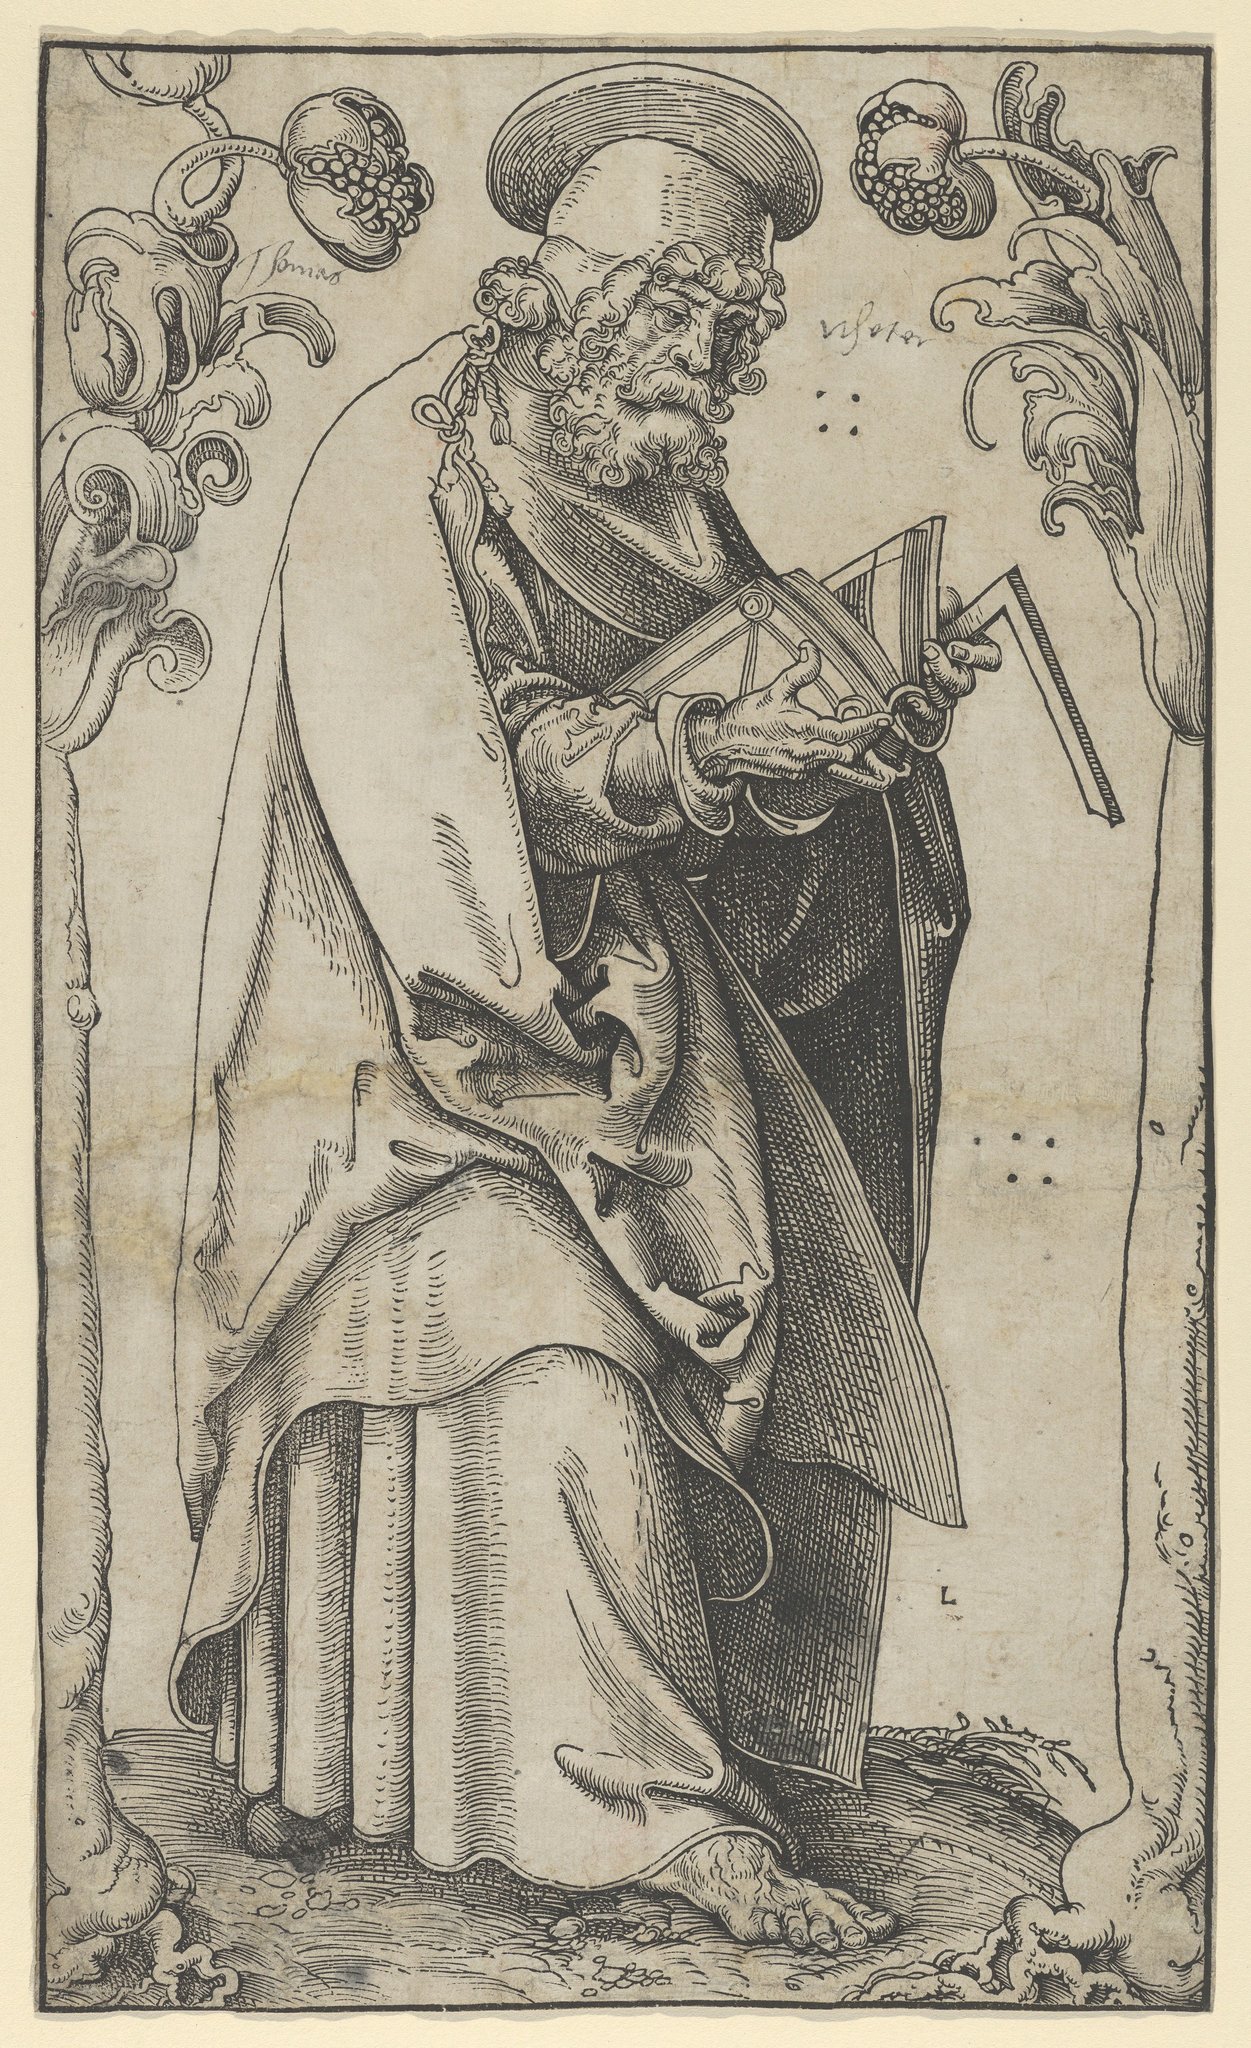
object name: print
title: Matthew from Christ, the Apostles and St. Paul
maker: lucas cranach the elder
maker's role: artist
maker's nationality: german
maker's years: 1472-1553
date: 1472-1553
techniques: woodcut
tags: books,reading,saint matthew